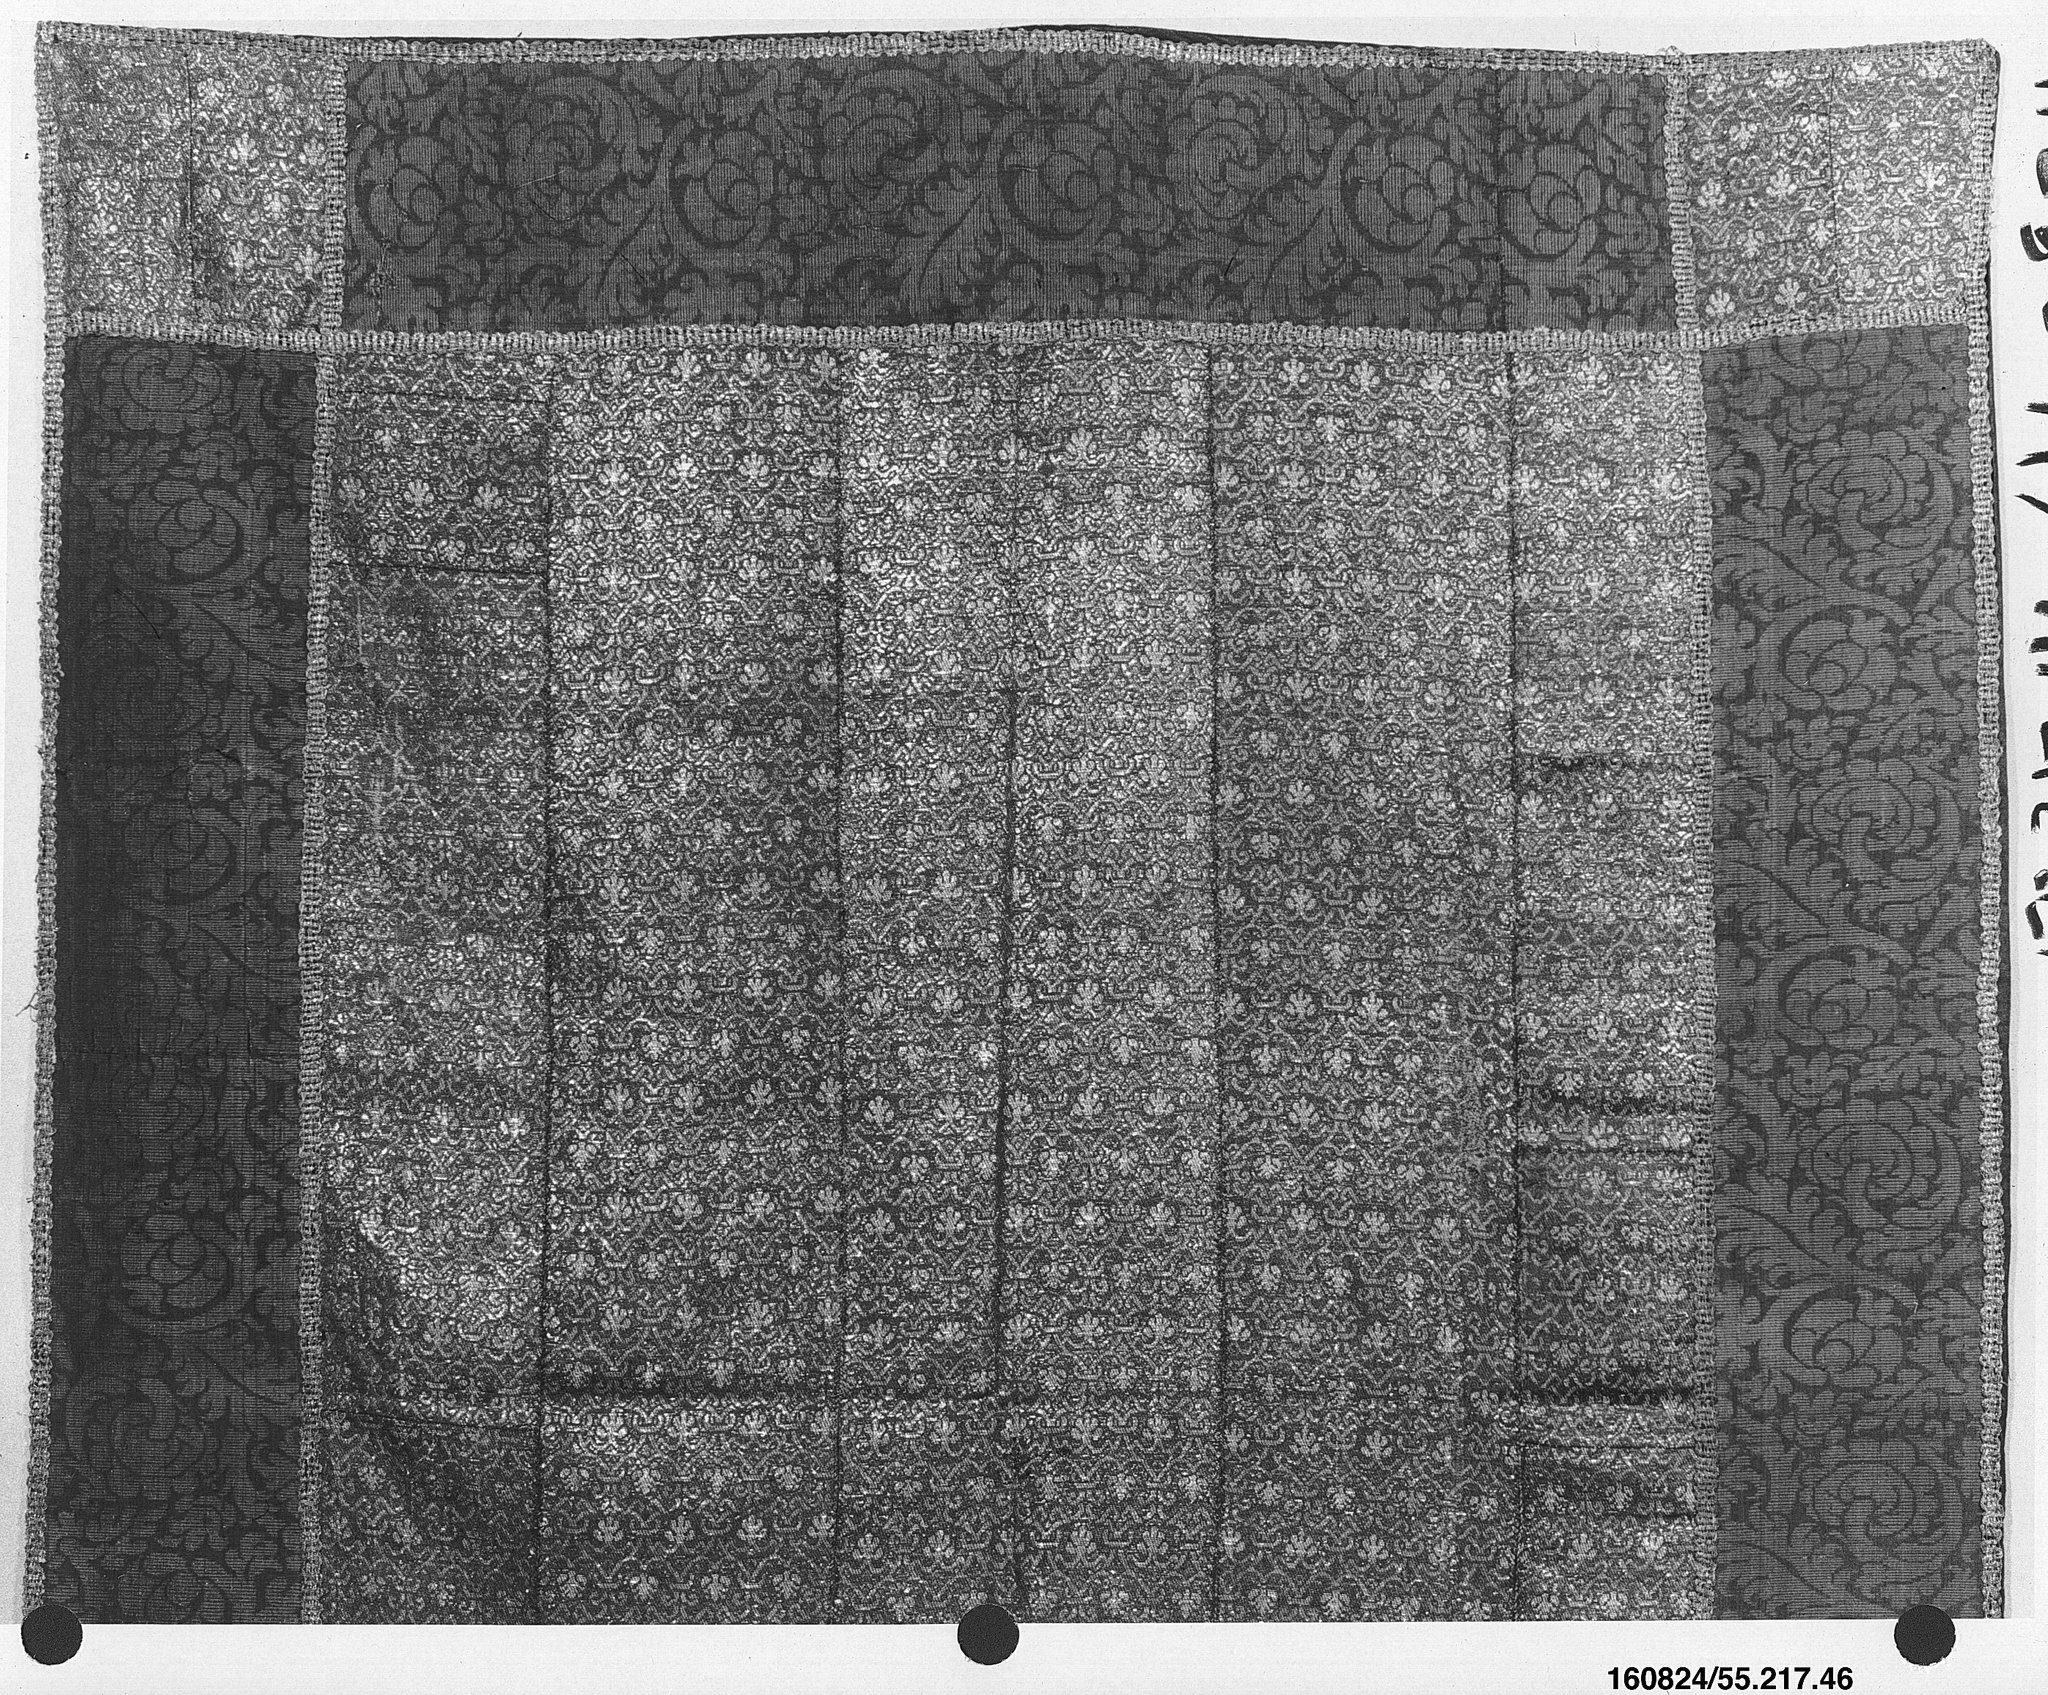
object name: panel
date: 1601-1700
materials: metal thread, silk